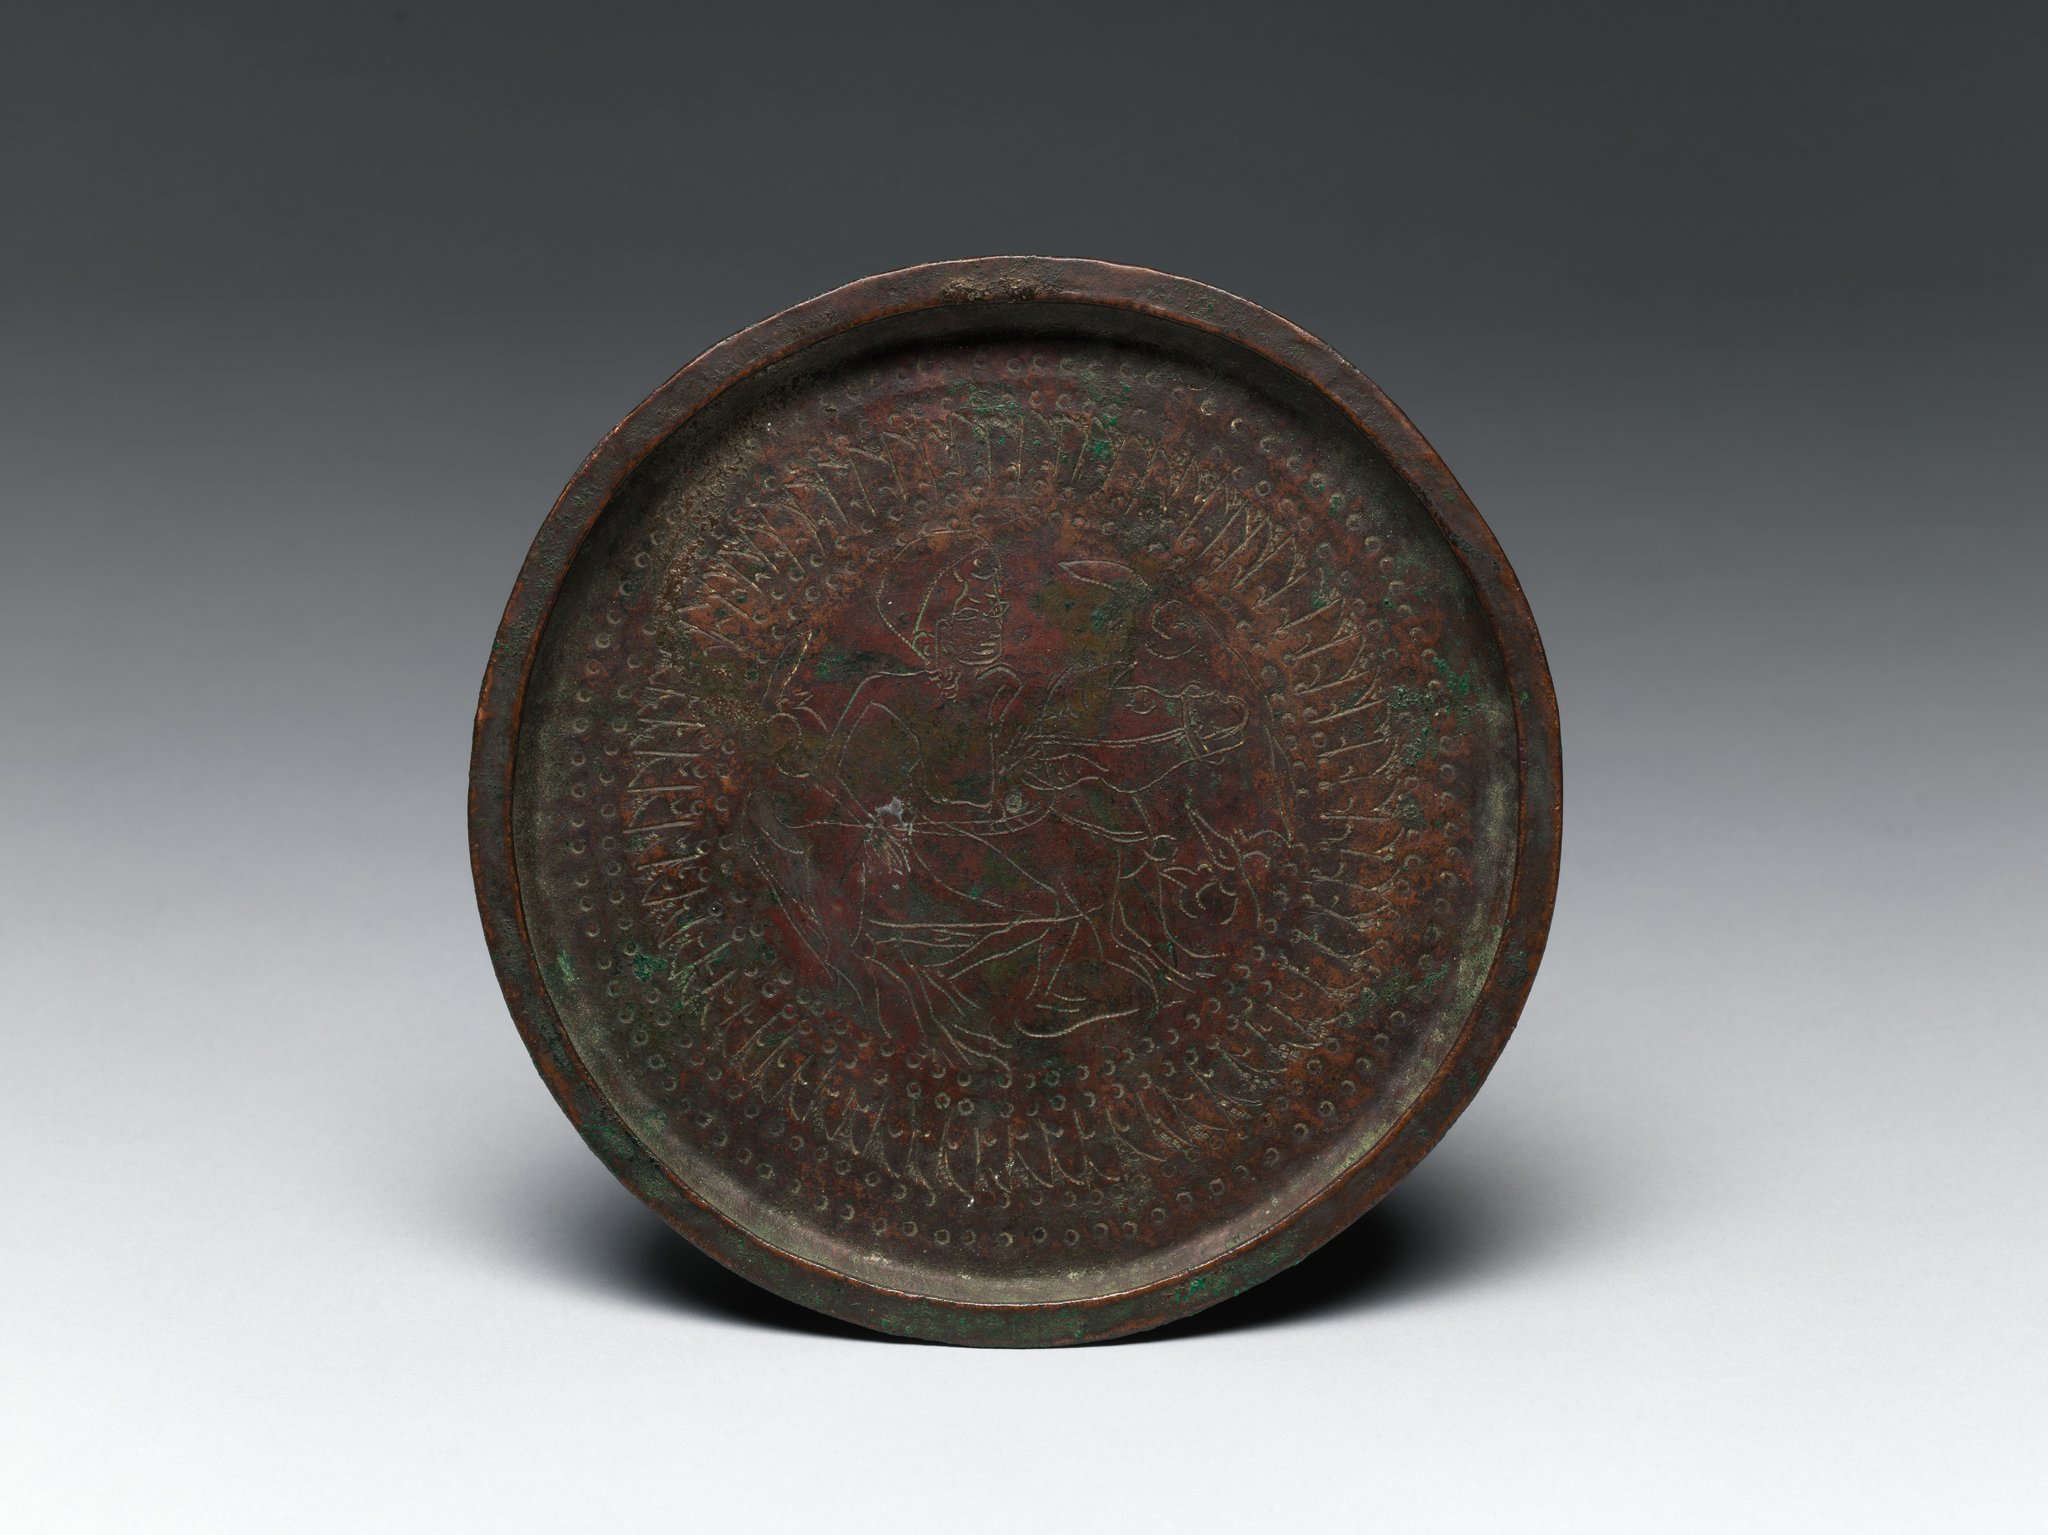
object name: offering tray talam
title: Offering Tray (Talam)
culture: indonesian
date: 901-1400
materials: bronze